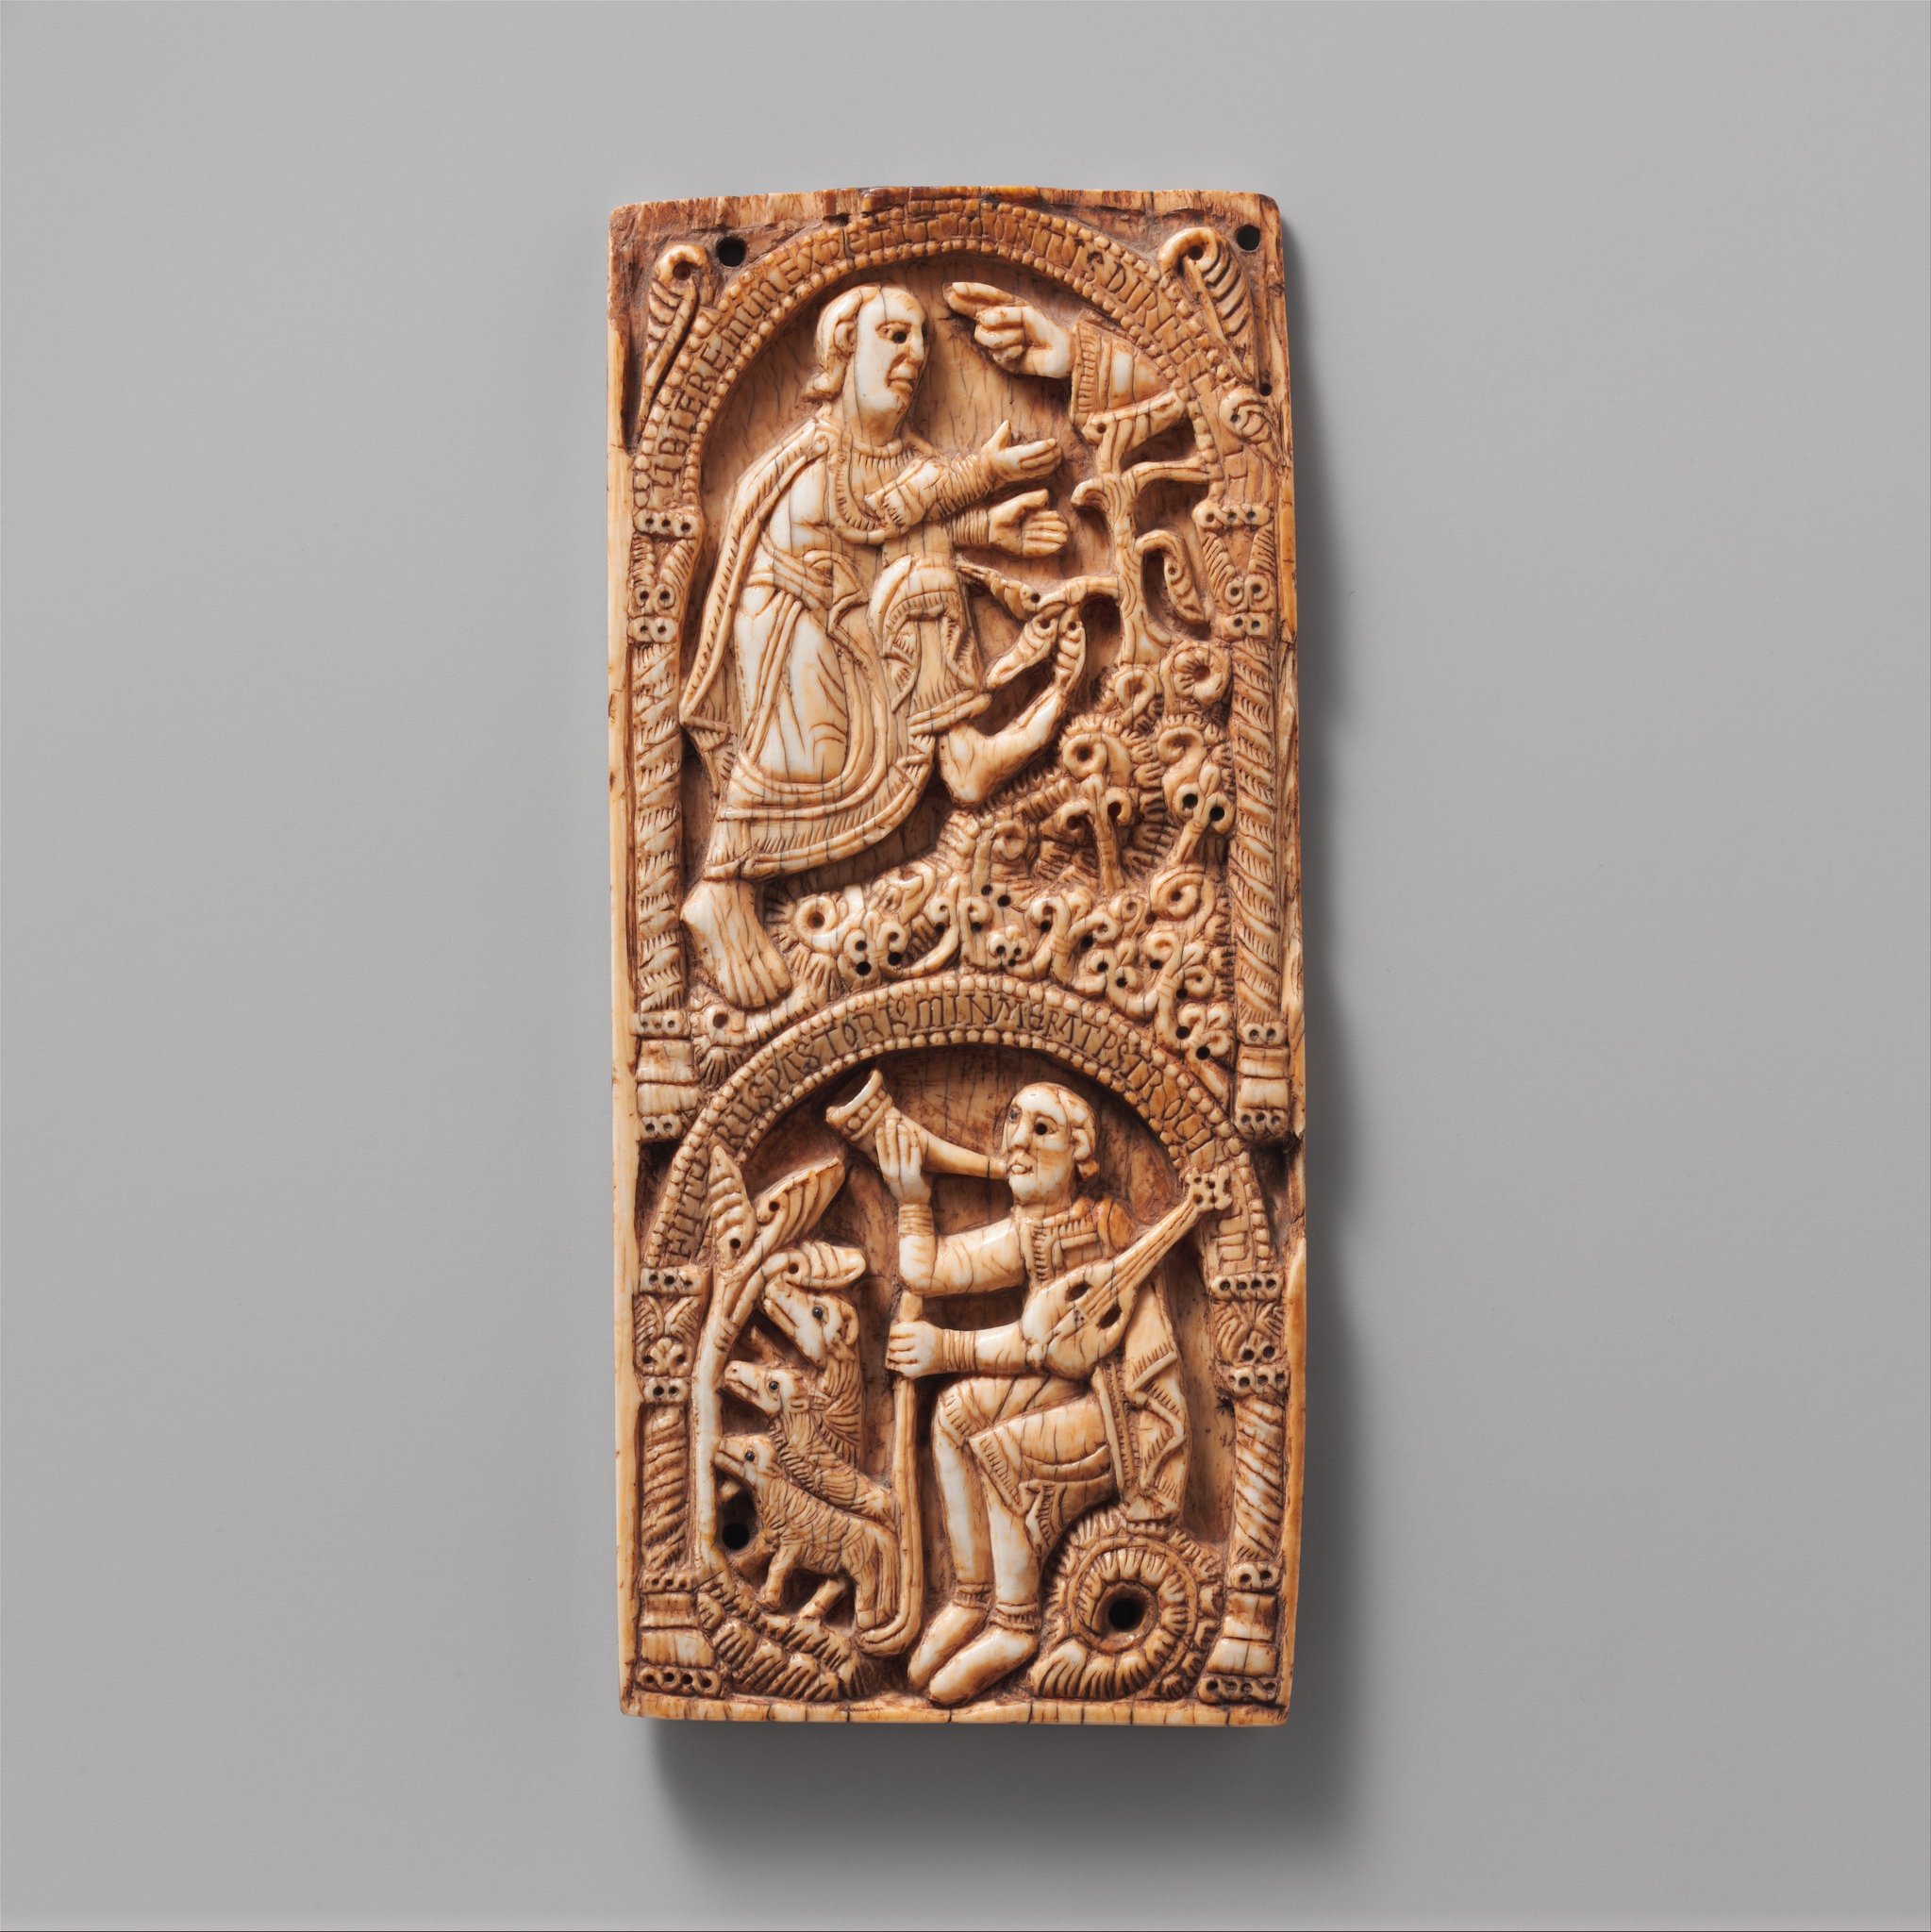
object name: panel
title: Panel with San Millán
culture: spanish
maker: master engelram and his son redolfo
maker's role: artist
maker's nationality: spanish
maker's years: 1060-1095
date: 1060-1080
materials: glass, ivory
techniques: inlay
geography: spain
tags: musical instruments,men,sheep,saints